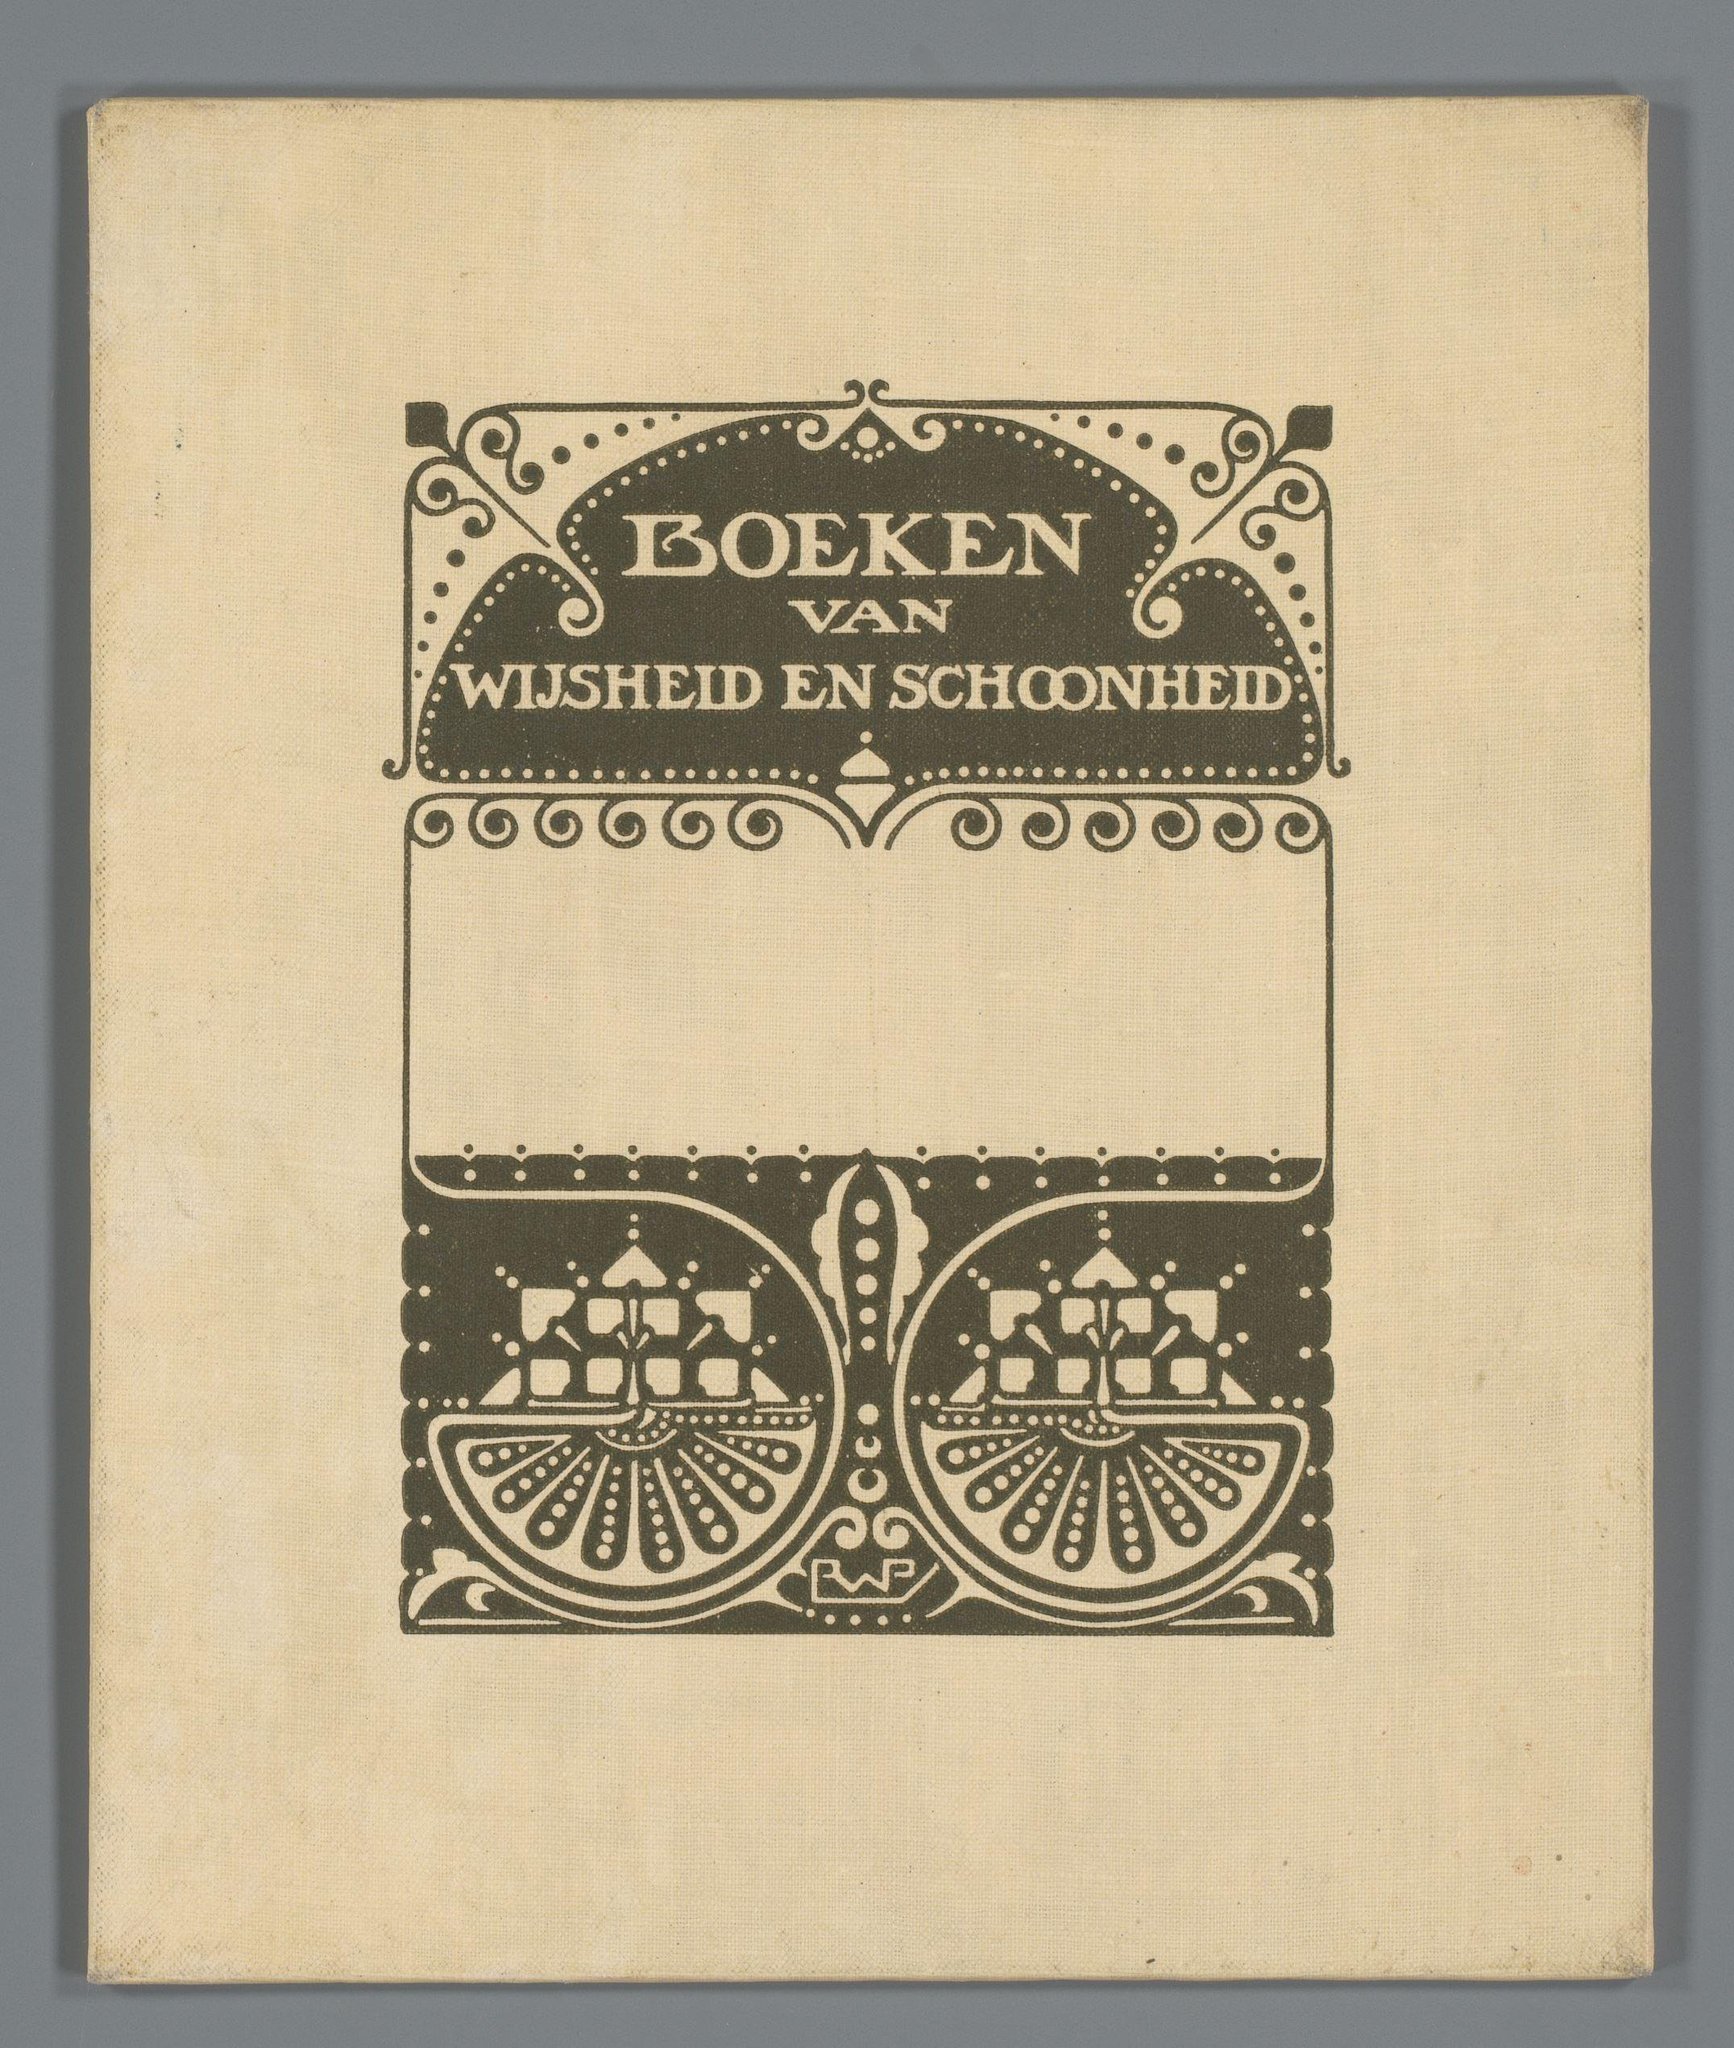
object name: binding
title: Voorplat van een boekband voor: Boeken van wijsheid en schoonheid, 1913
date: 1913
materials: cardboard, linen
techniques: printing block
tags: ornaments ~ art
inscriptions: collector's mark: ‘R:MVS.’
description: Bandontwerp voor: Boeken van wijsheid en schoonheid. Baarn: Hollandia-Drukkerij, 1913.